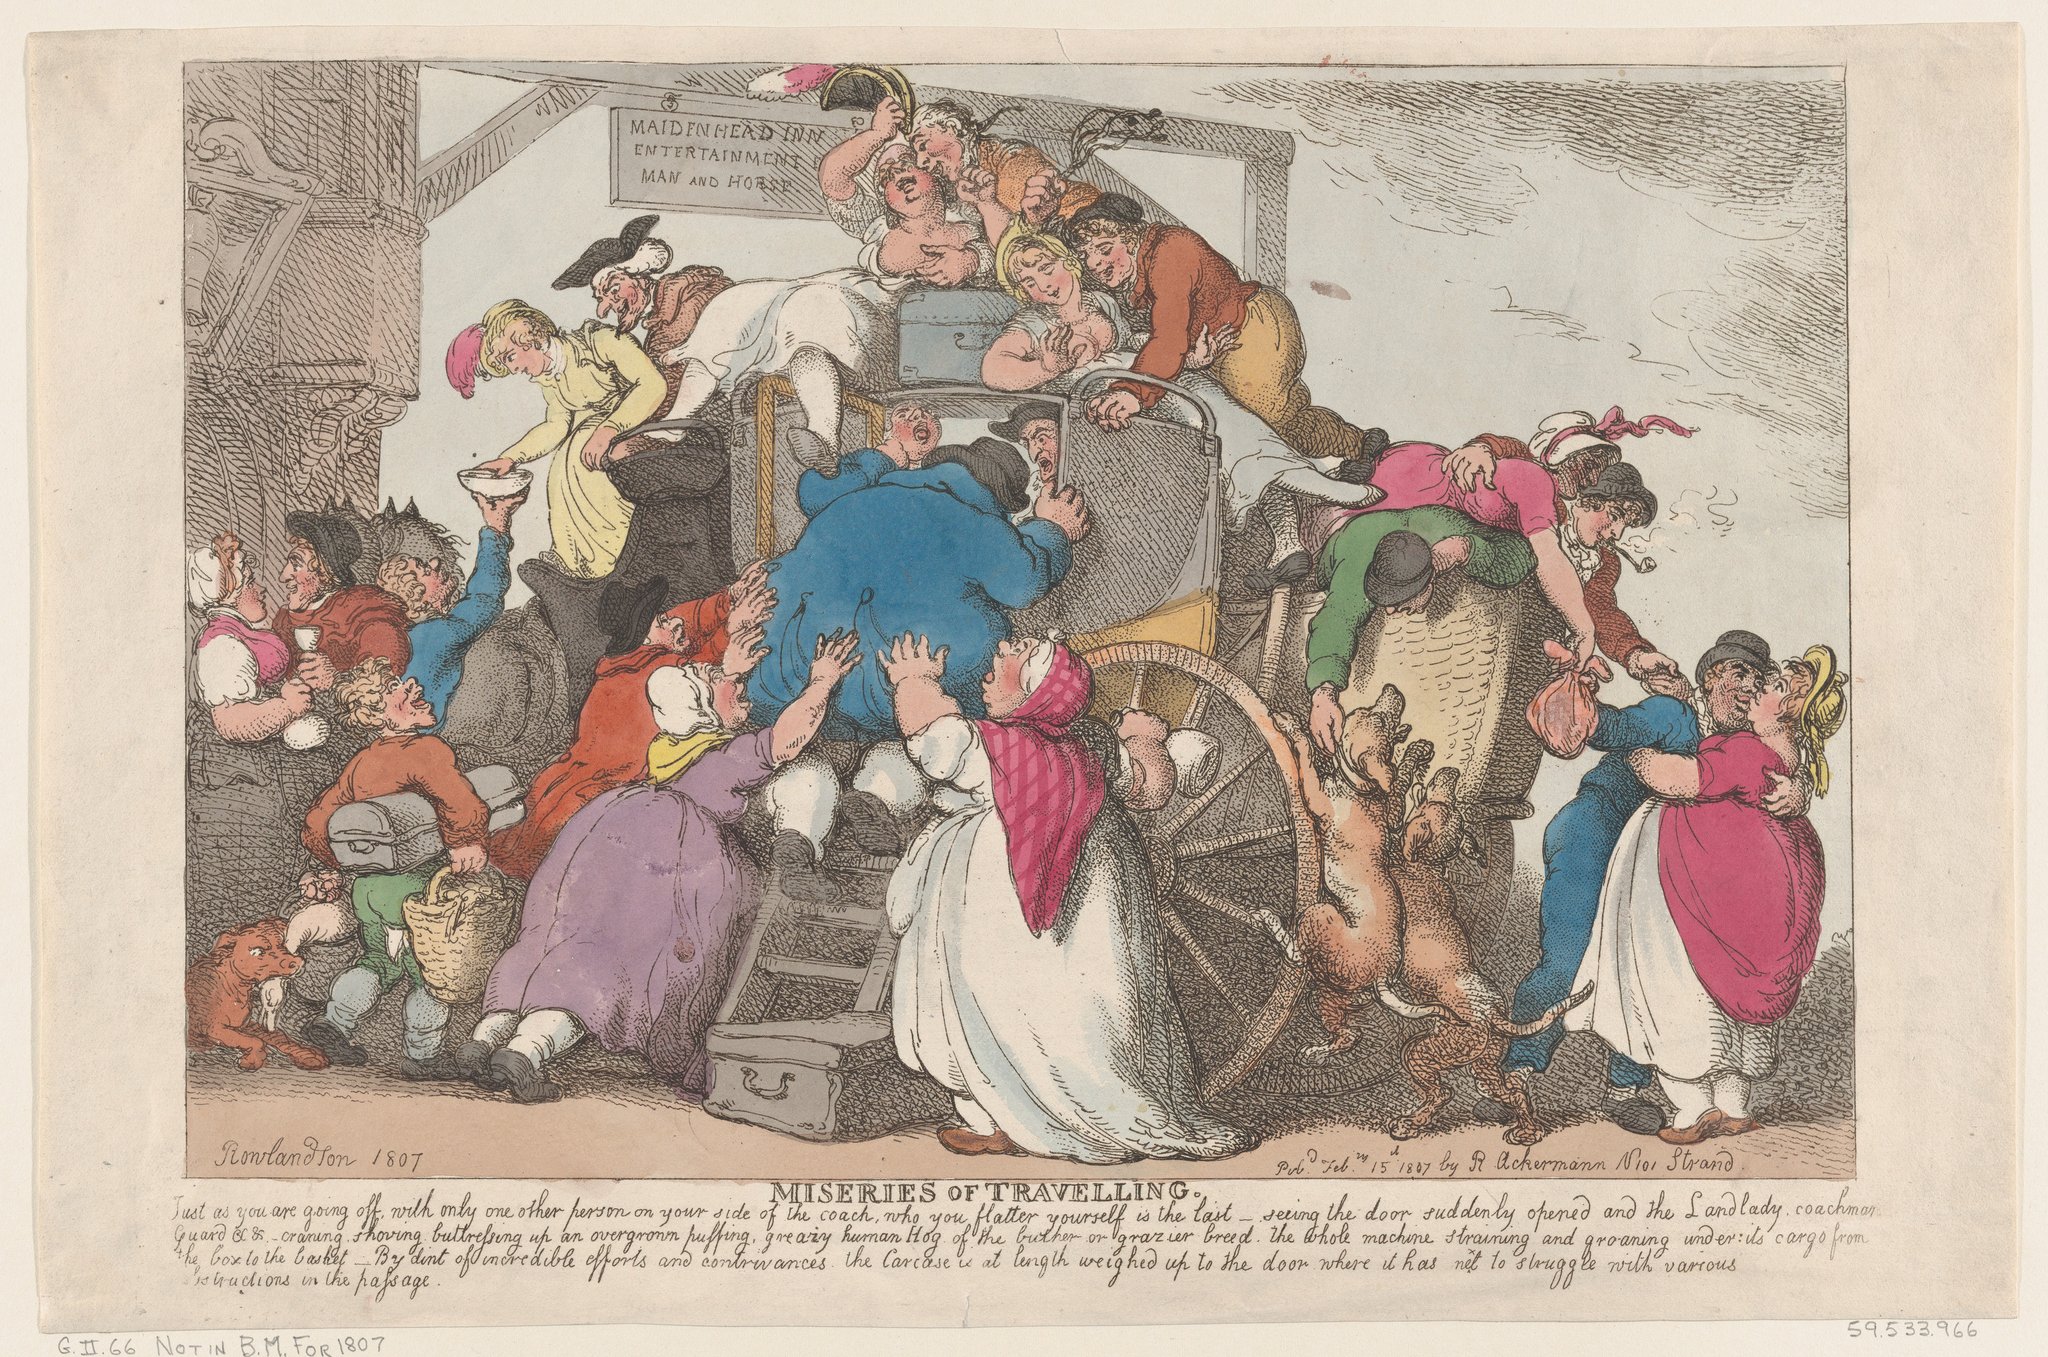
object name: print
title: Miseries of Travelling: the Overloaded Coach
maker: thomas rowlandson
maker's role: artist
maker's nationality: british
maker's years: 1757-1827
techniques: etching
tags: satire,men,women,dogs,carriages